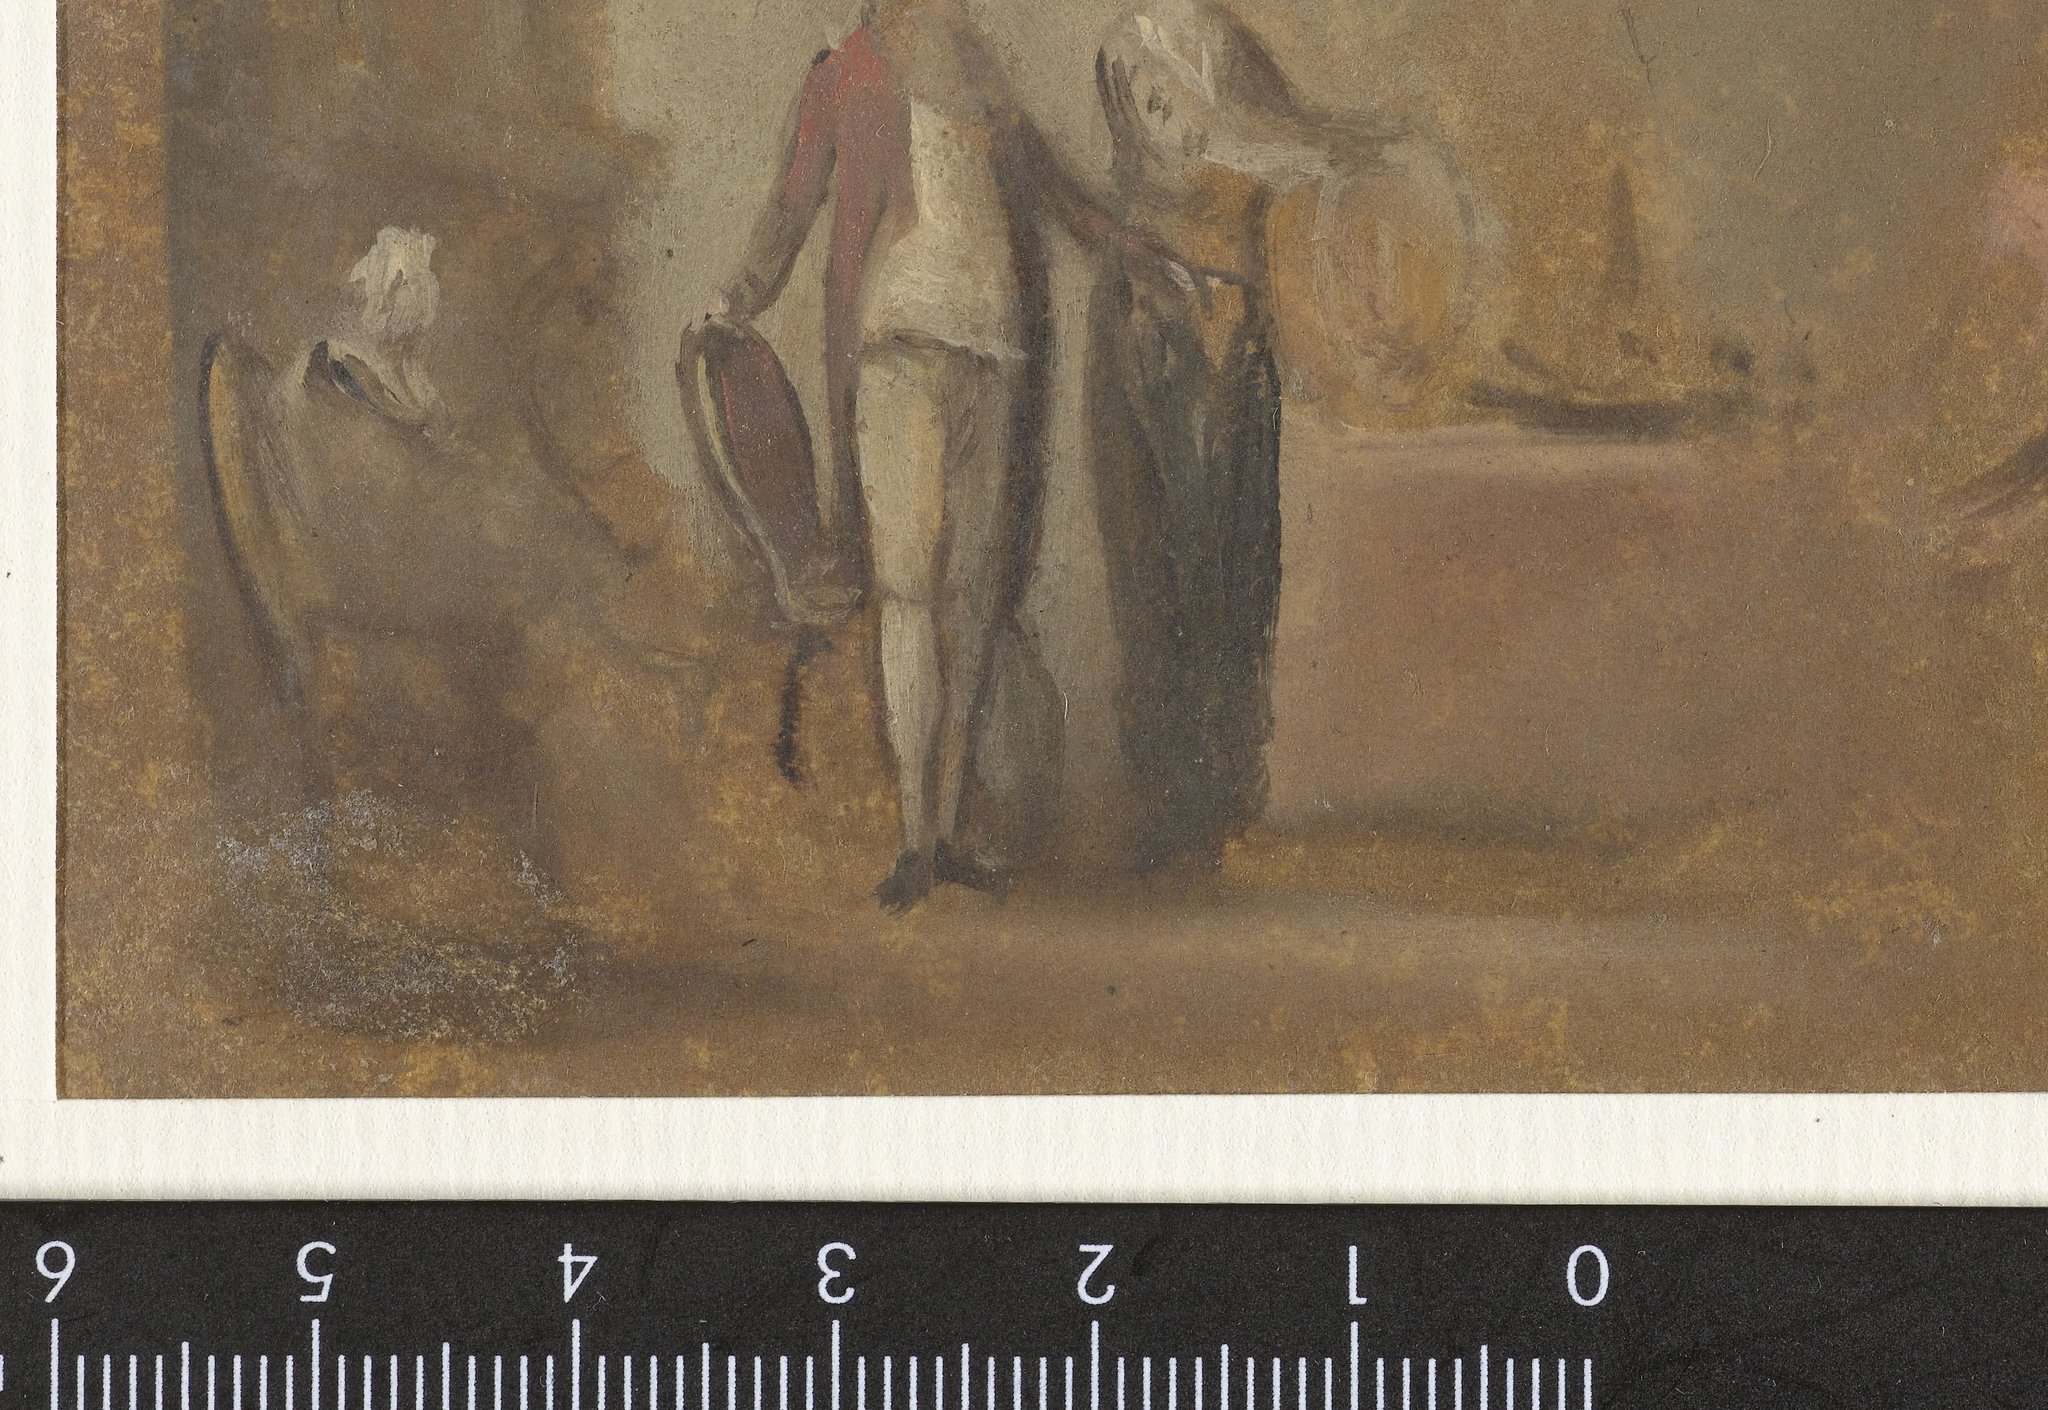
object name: drawing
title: Schets voor een familiegroep in interieur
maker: Anonymous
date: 1700-1800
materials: oil, paper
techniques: brush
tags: family group, especially parents with their child(ren)